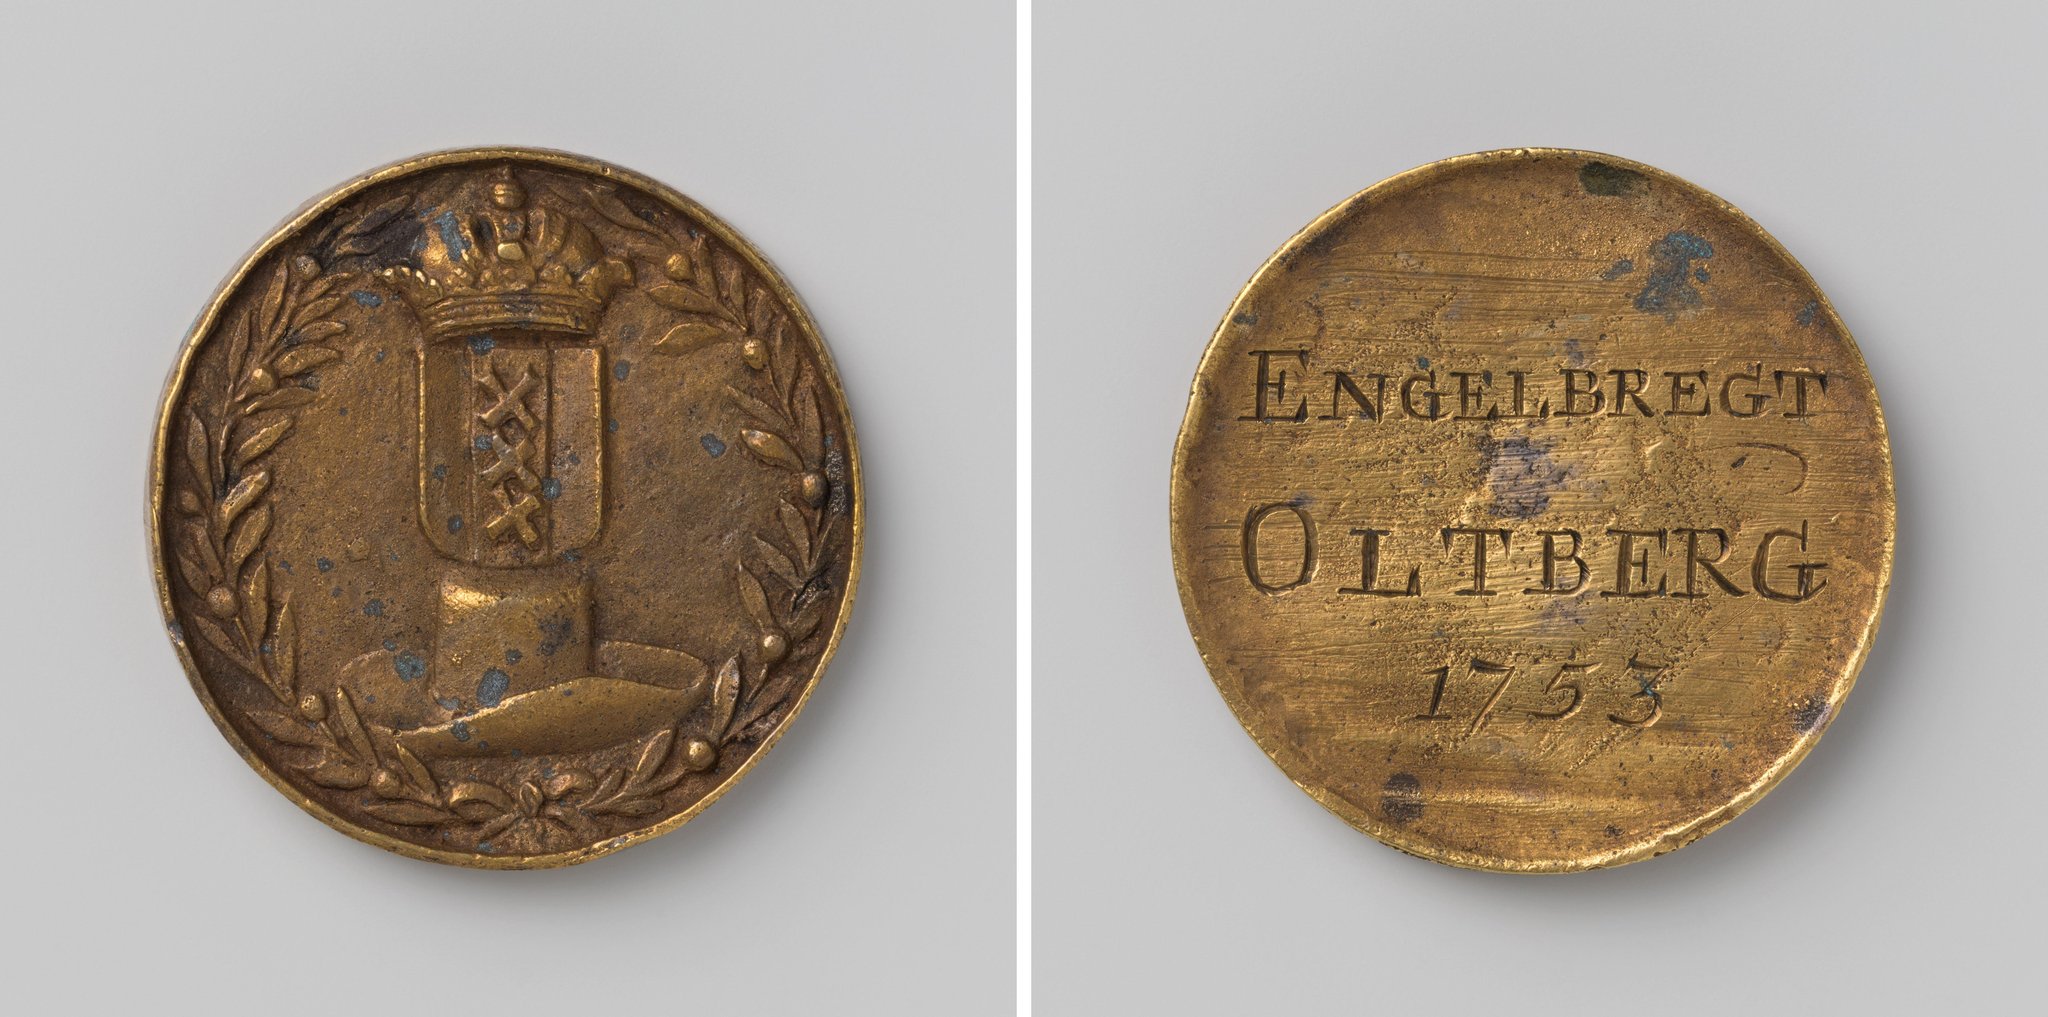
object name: medal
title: Hoedemakersgilde te Amsterdam, gildepenning van Engelbregt Oltberg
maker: Anonymous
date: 1753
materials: brass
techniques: casting, engraving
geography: amsterdam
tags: amsterdam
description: Guilds were urban organisations of people in specific occupations. The guild represented the interests of the profession. Each member had a token as proof of membership. The person’s name was engraved on one side of the token, often together with the arms of the guild or of the city in which it was based. The other side carried a motif signifying the occupation represented by the guild.